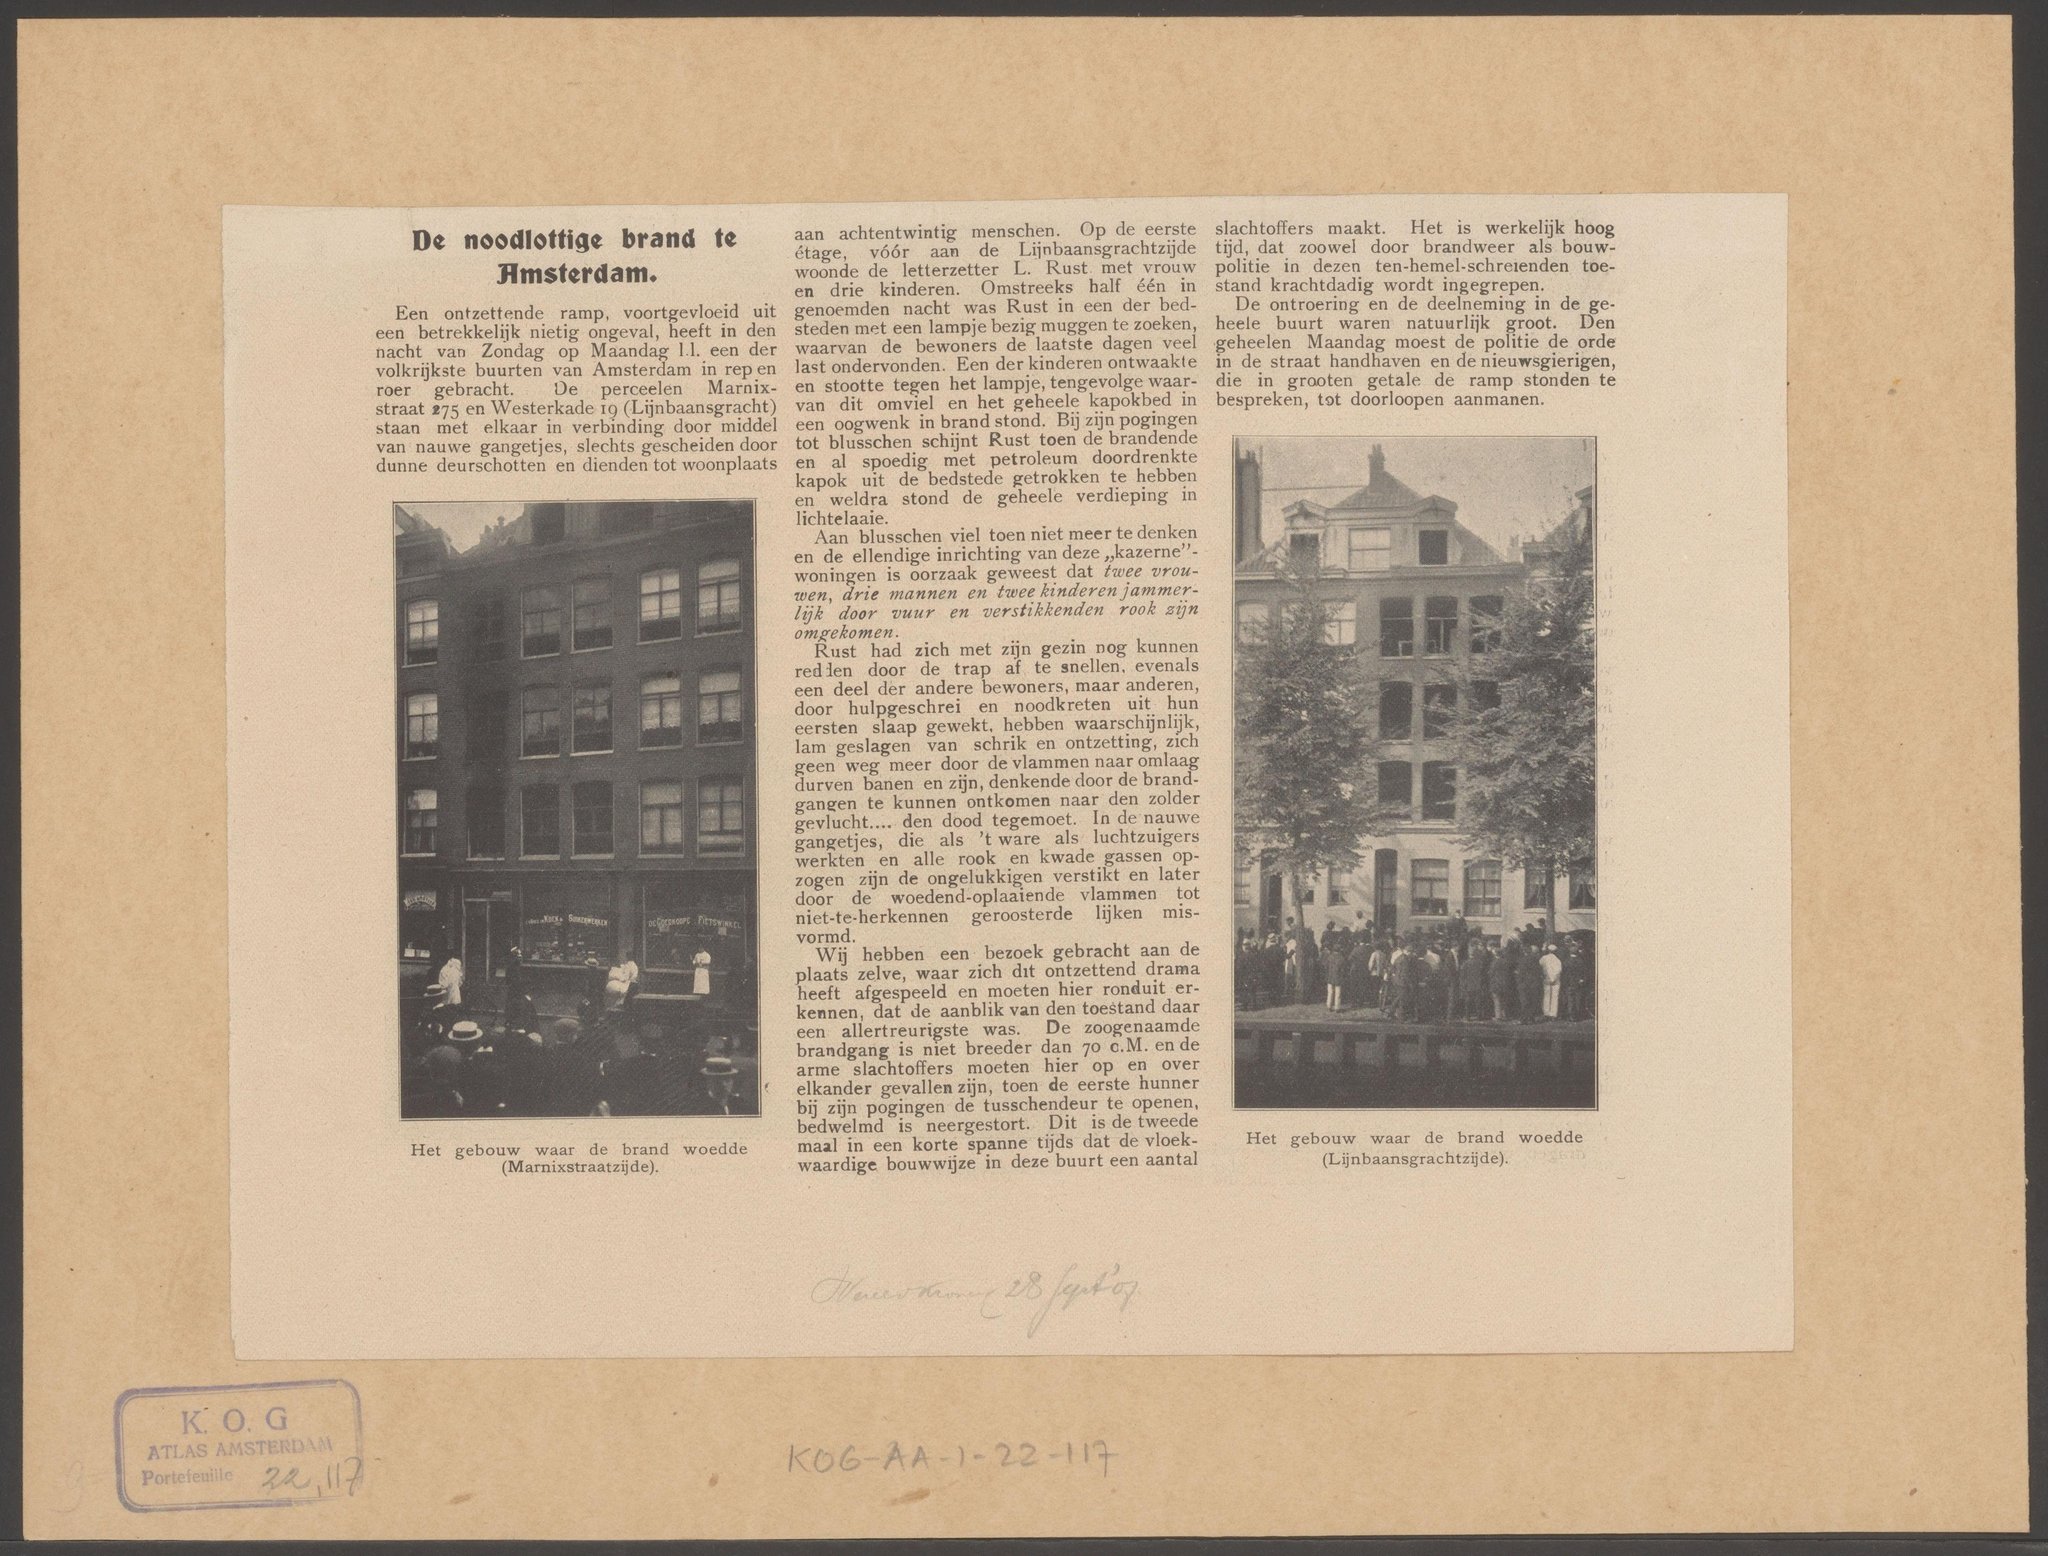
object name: photomechanical print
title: Het gebouw waar de brand woedde (Marnixstraatzijde) / Het gebouw waar de brand woedde (Lijnbaansgrachtzijde)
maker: Anonymous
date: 1907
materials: paper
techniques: letterpress printing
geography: netherlands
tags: urban housing, crowd, mob, ruin of a building ~ architecture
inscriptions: collector's mark: Lugt 1641b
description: Onderwerpsrubriek binnen de Atlas Amsterdam: Gemeentewerken: B. Branden in particuliere gebouwen.